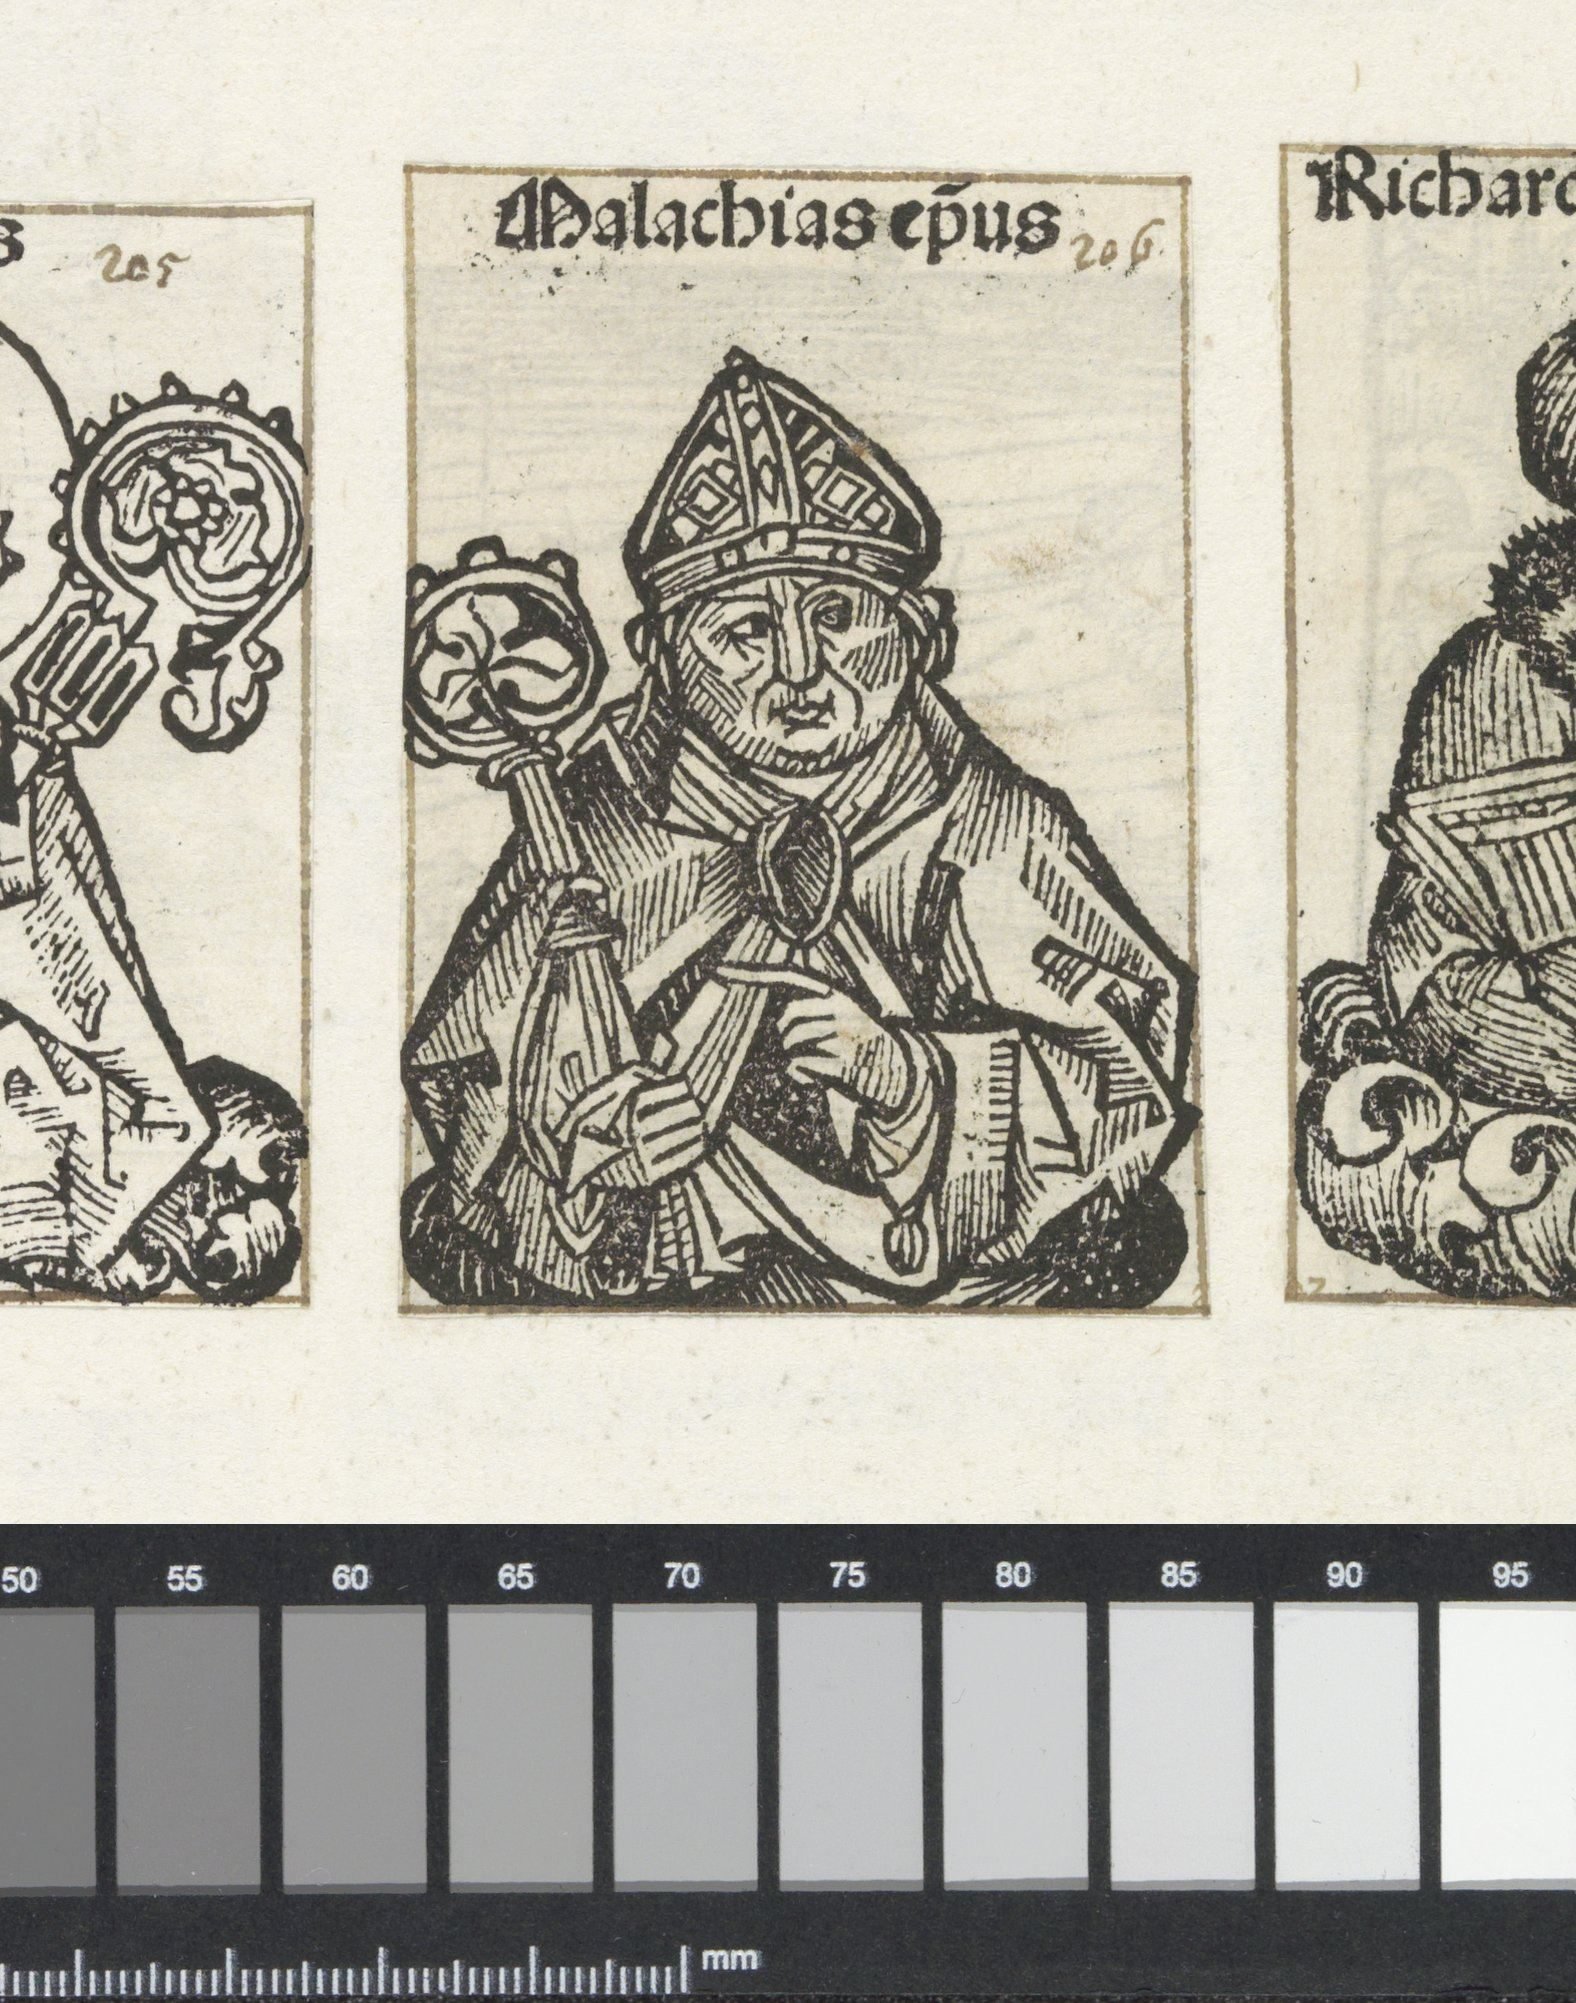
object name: print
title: Malachias ep[iscopu]s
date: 1493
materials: paper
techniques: letterpress printing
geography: nuremberg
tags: archbishop, bishop, etc. (roman catholic)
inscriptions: inscription: ‘206’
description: De houtsnede wordt herhaaldelijk gebruikt als boekillustratie in de Liber Chronicarum (of Neurenbergkroniek) van Hartmann Schedel, verschenen in het Latijn en Duits in 1493. Zie de Latijnse uitgave, folio 200v.